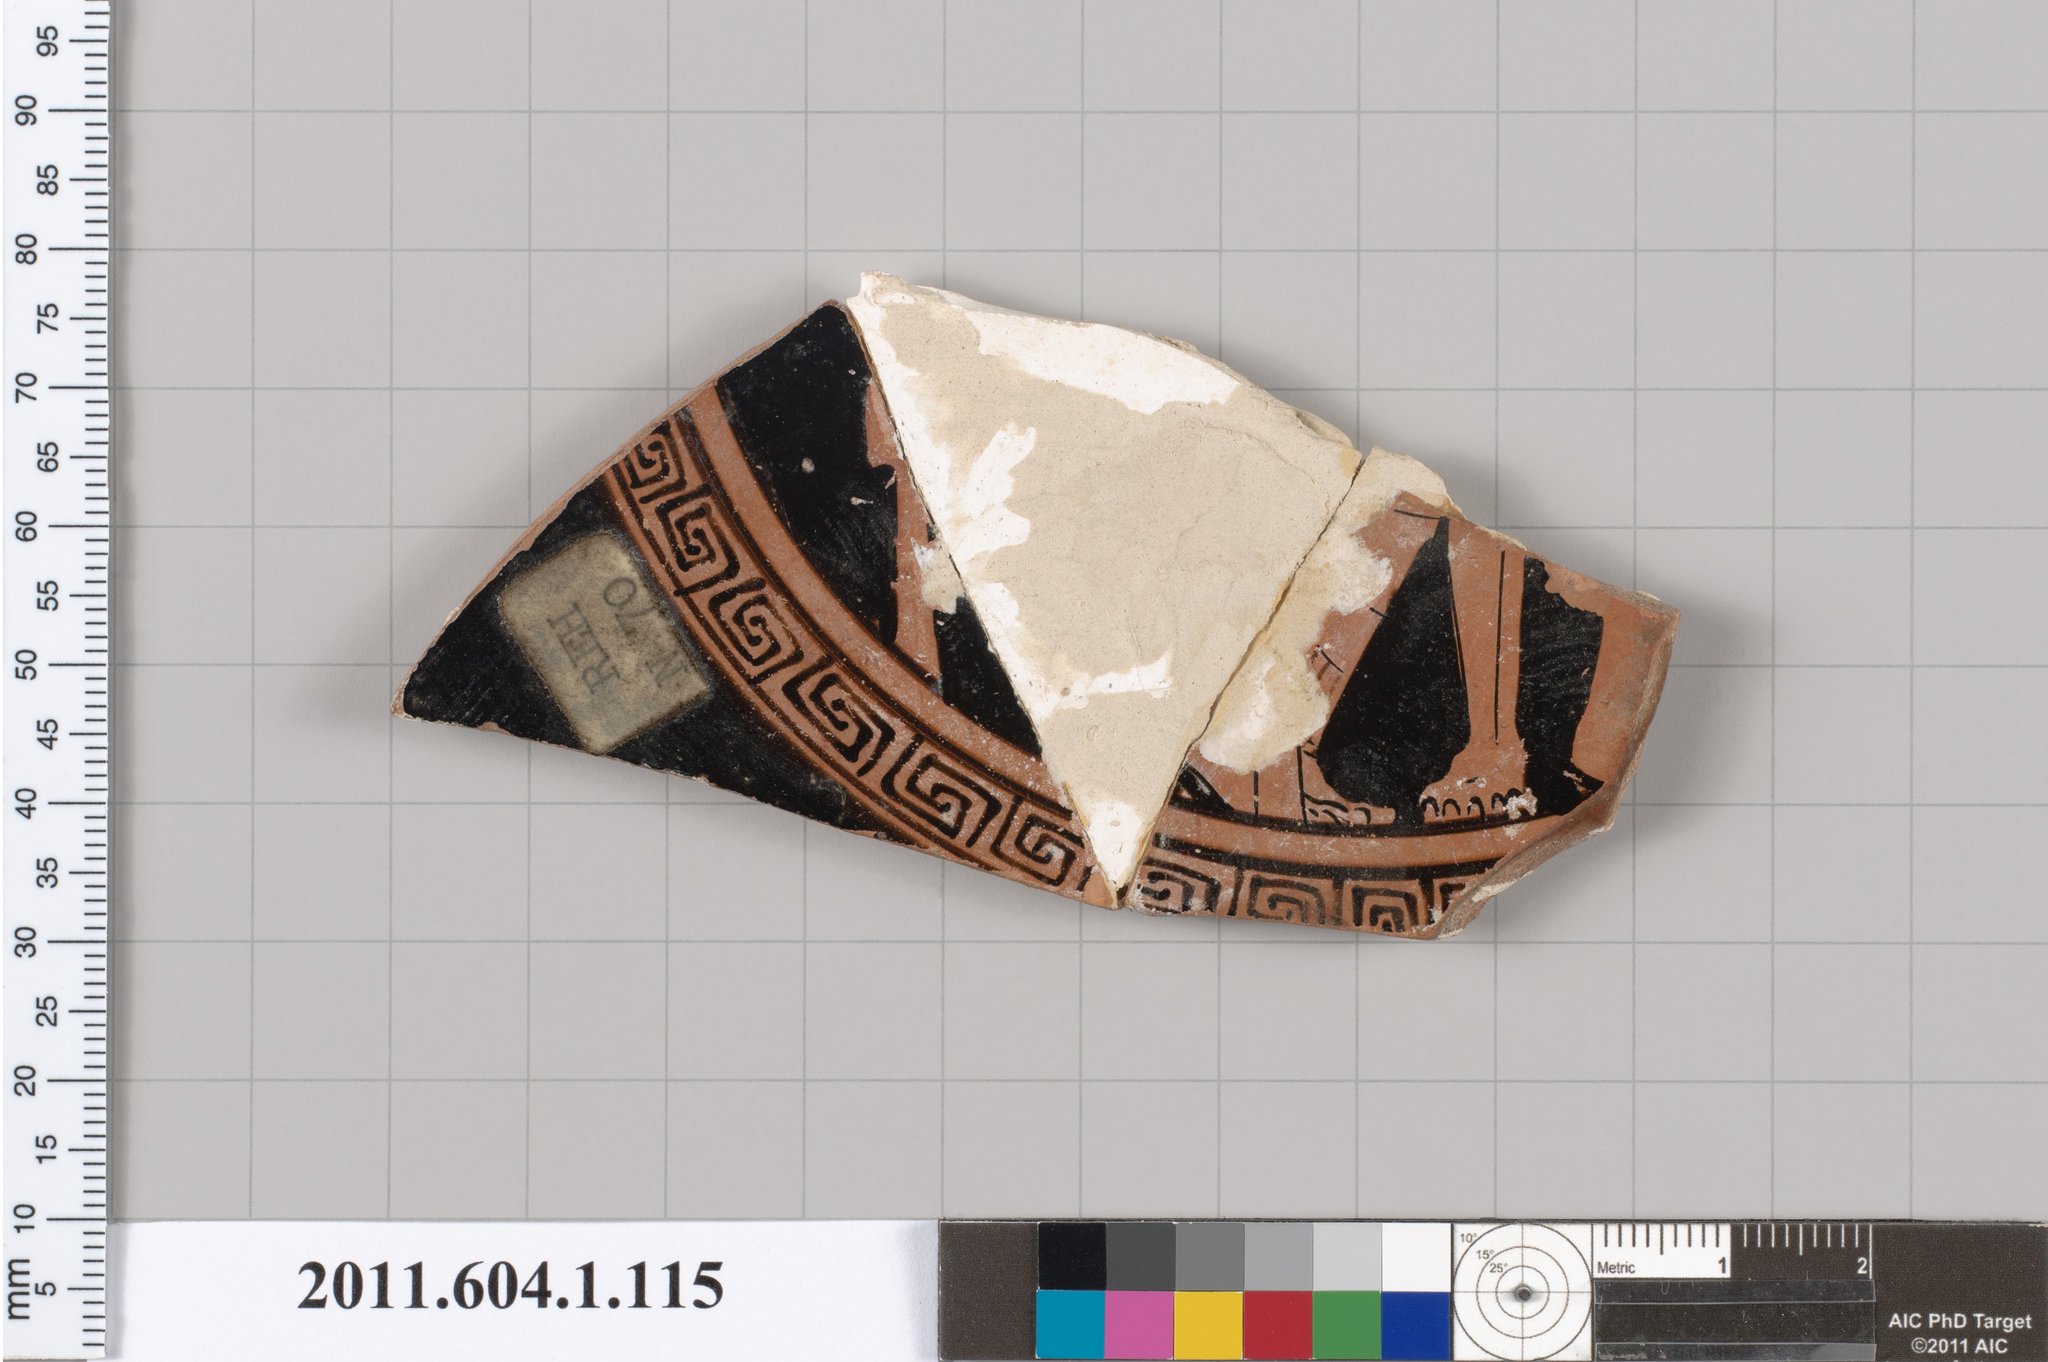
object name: kylix fragment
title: Terracotta fragment of a kylix (drinking cup)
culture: greek, attic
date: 470-450 BCE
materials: terracotta